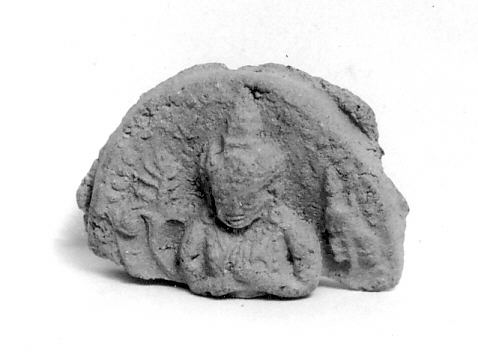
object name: plaque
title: Votive Plaque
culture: central asian or tibetan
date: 1401-1700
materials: clay